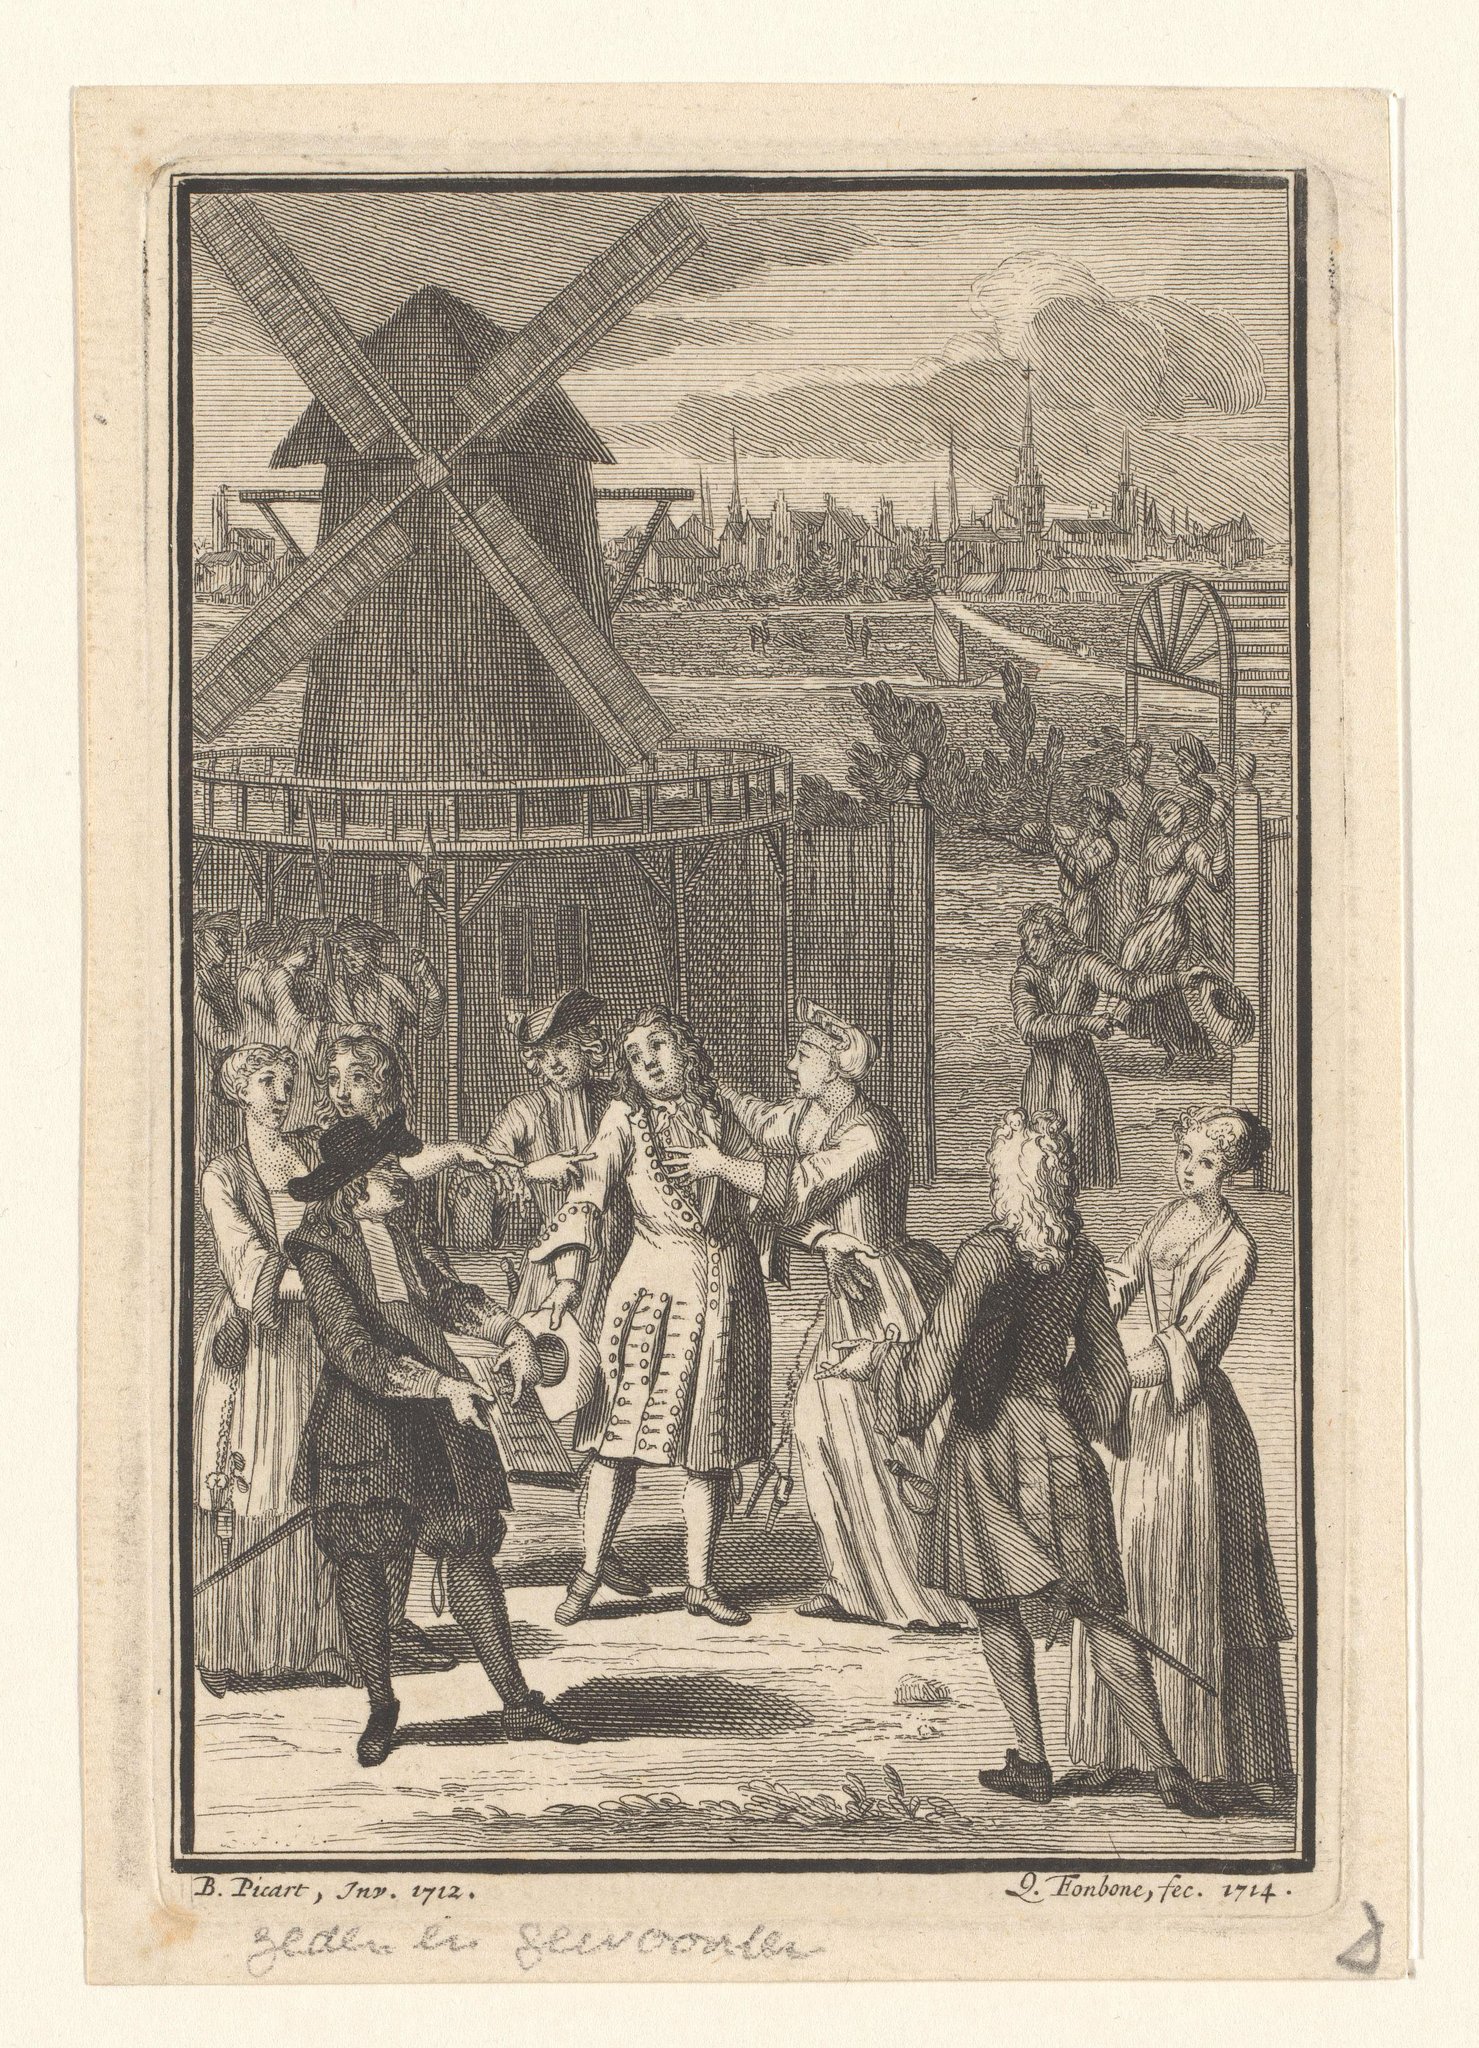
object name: print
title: Groep mensen voor een molen, mogelijk een scène uit een toneelstuk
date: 1714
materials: paper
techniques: etching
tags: city-view, and landscape with man-made constructions, theatre, theatrical performance, windmill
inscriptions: collector's mark: Lugt 2228, collector's mark: Lugt 240